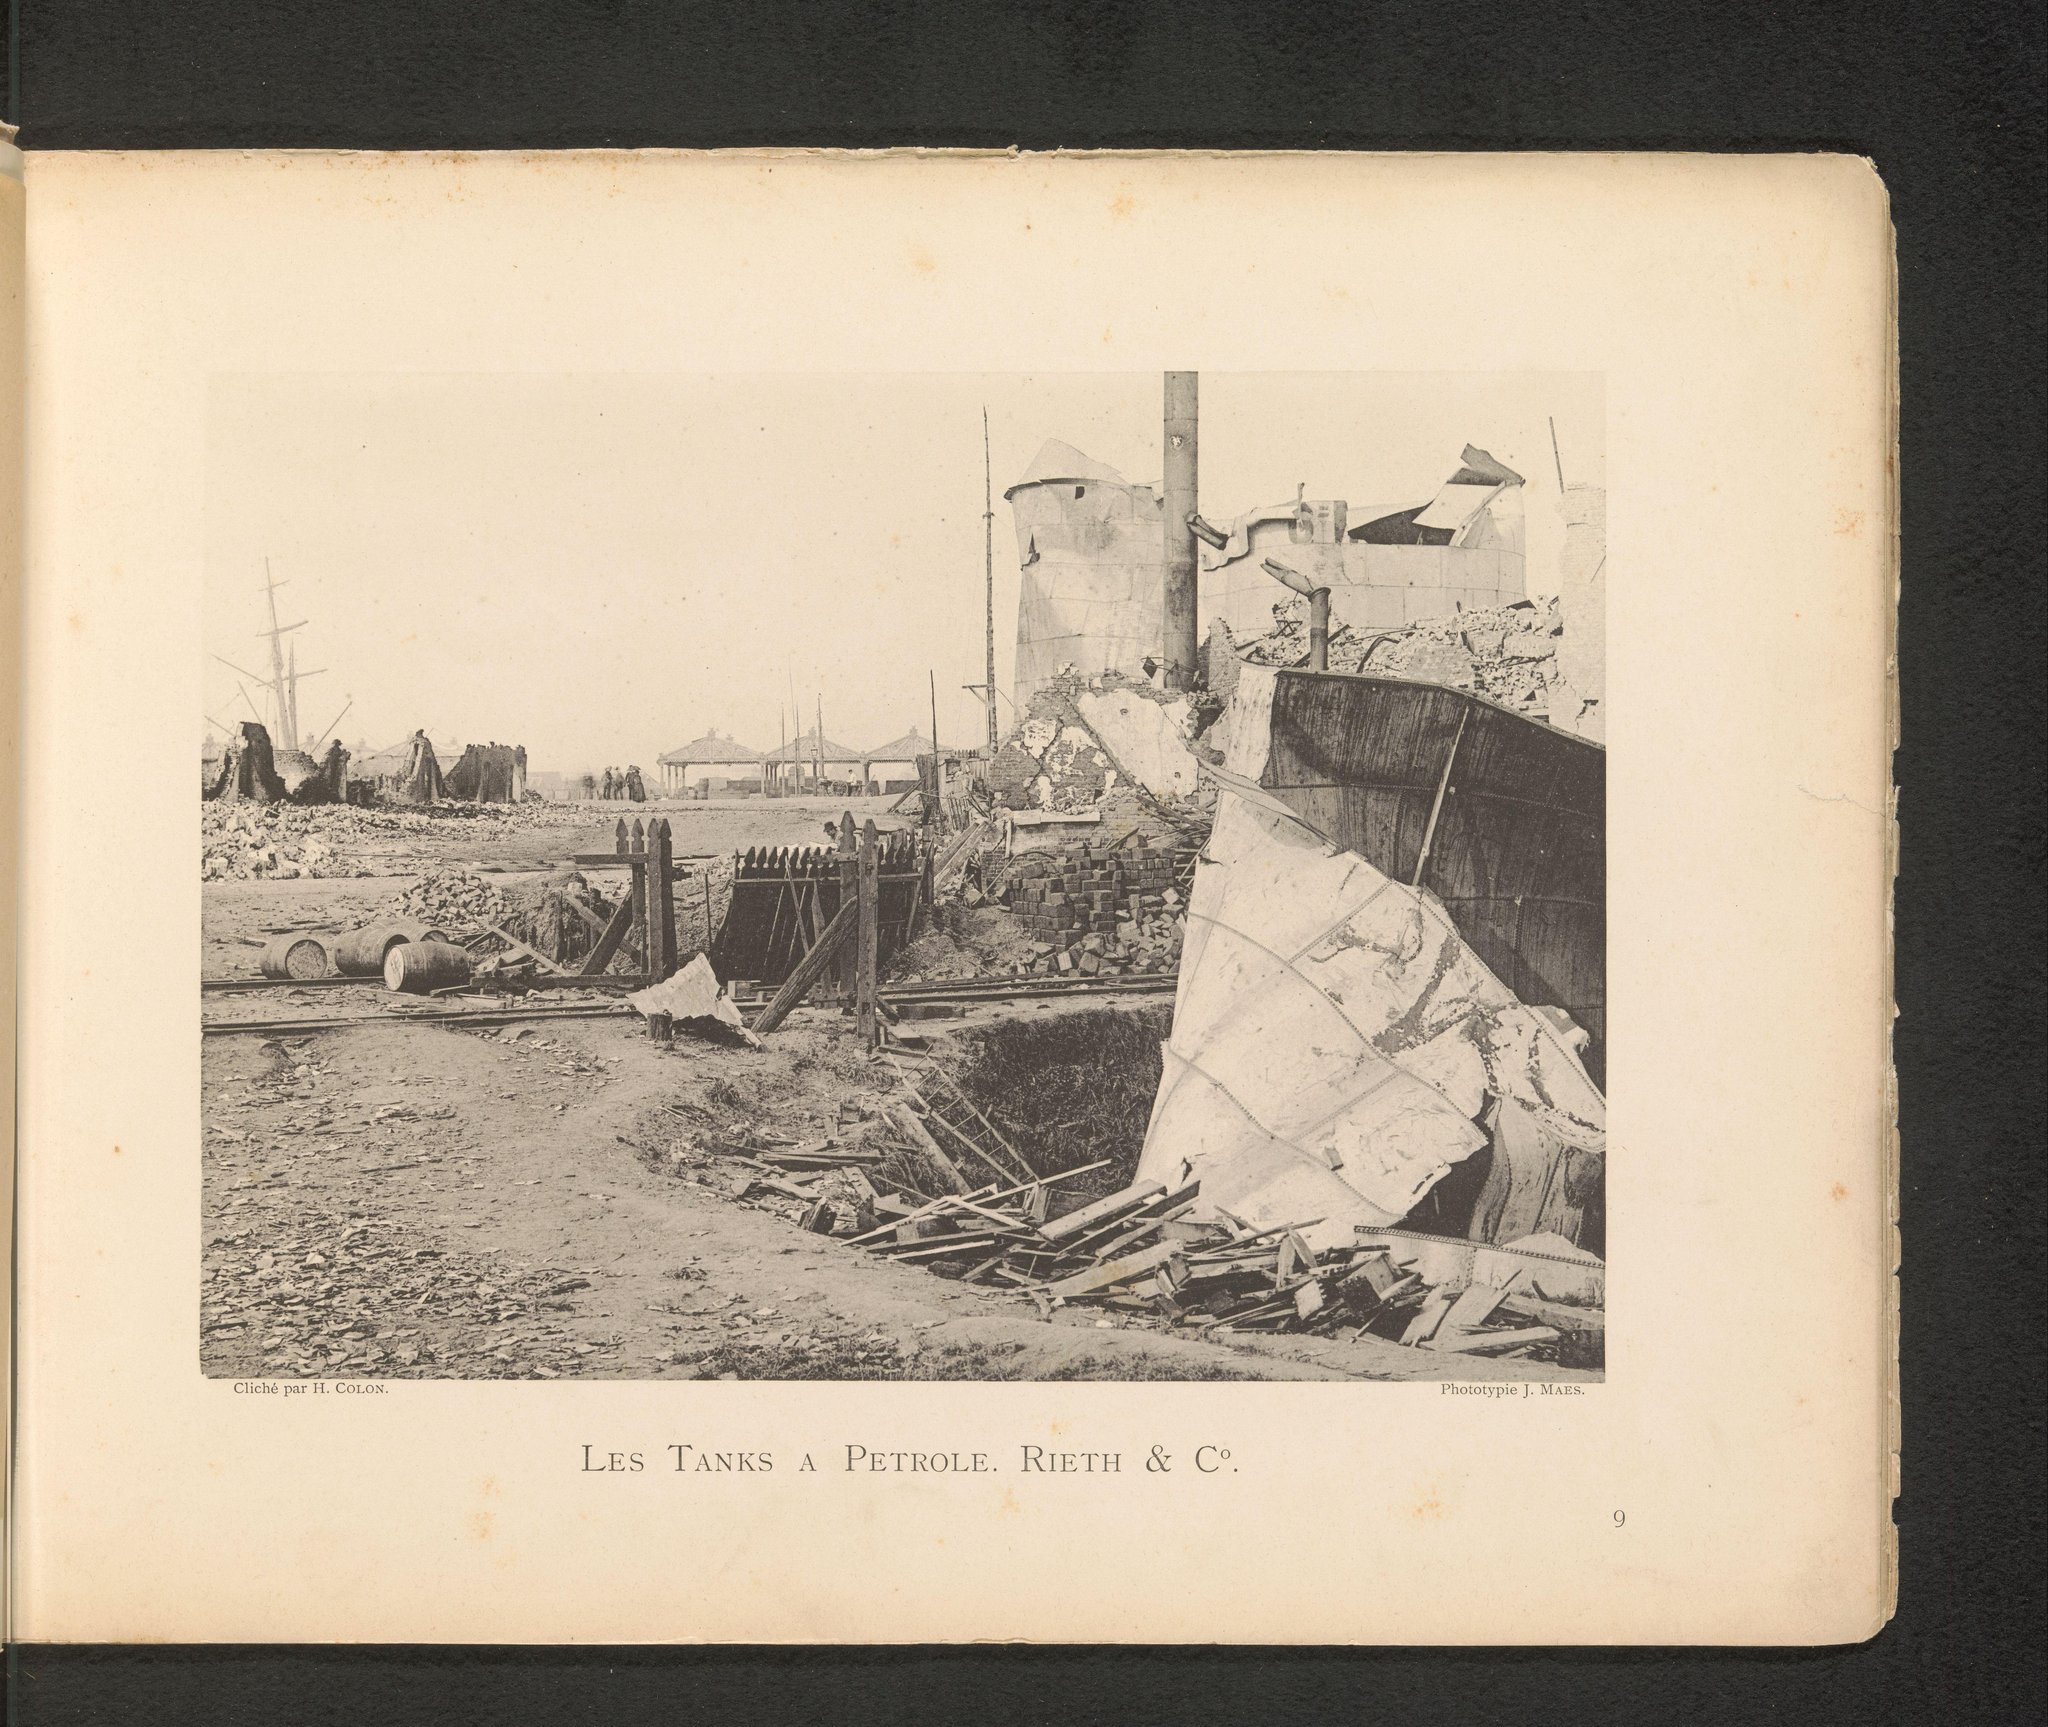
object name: photomechanical print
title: Olietanks van Rieth & co die zijn verwoest door de ontploffing van een munitiefabriek in Oosterweel bij Antwerpen op 6 september 1889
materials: paper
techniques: photograph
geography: oosterweel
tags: ruin of a building ~ architecture, oil tanks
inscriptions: number: ‘9’